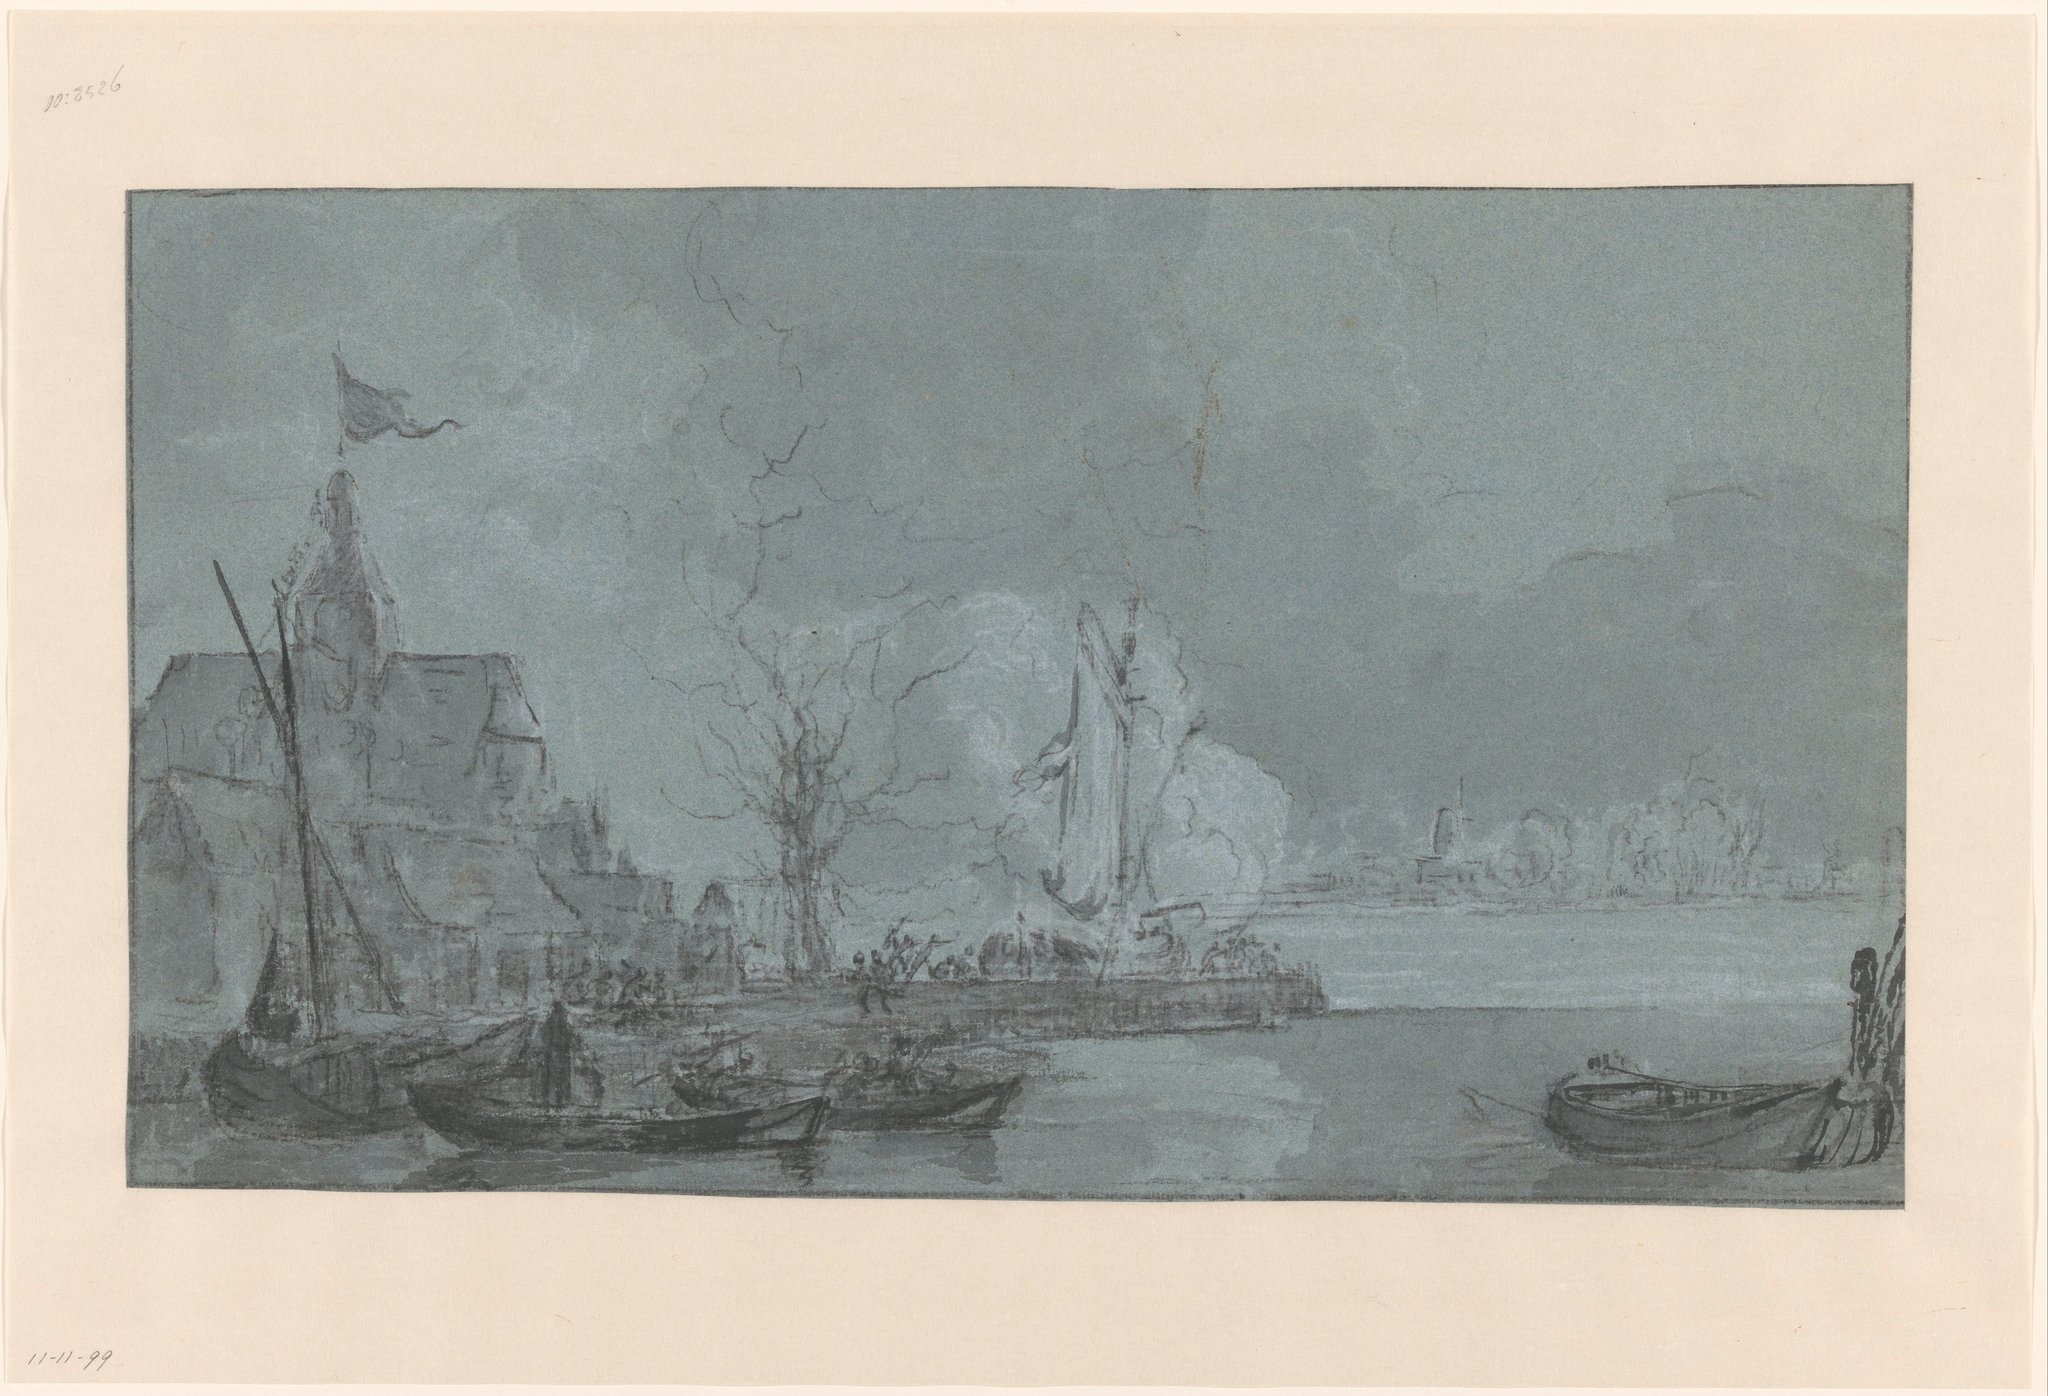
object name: drawing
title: Laatste schot van Dordrecht naar de Fransen in Papendrecht, 1813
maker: johannes christiaan schotel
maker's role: draughtsman, painter, print maker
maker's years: 1787-1838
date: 1813-1838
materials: chalk, paper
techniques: brush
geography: netherlands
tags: bombardment, dordrecht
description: Het afvuren van het laatste schot vanuit Dordrecht naar de Franse troepen in Papendrecht op 24 november 1813, waardoor de Fransen in allerijl vertrekken.